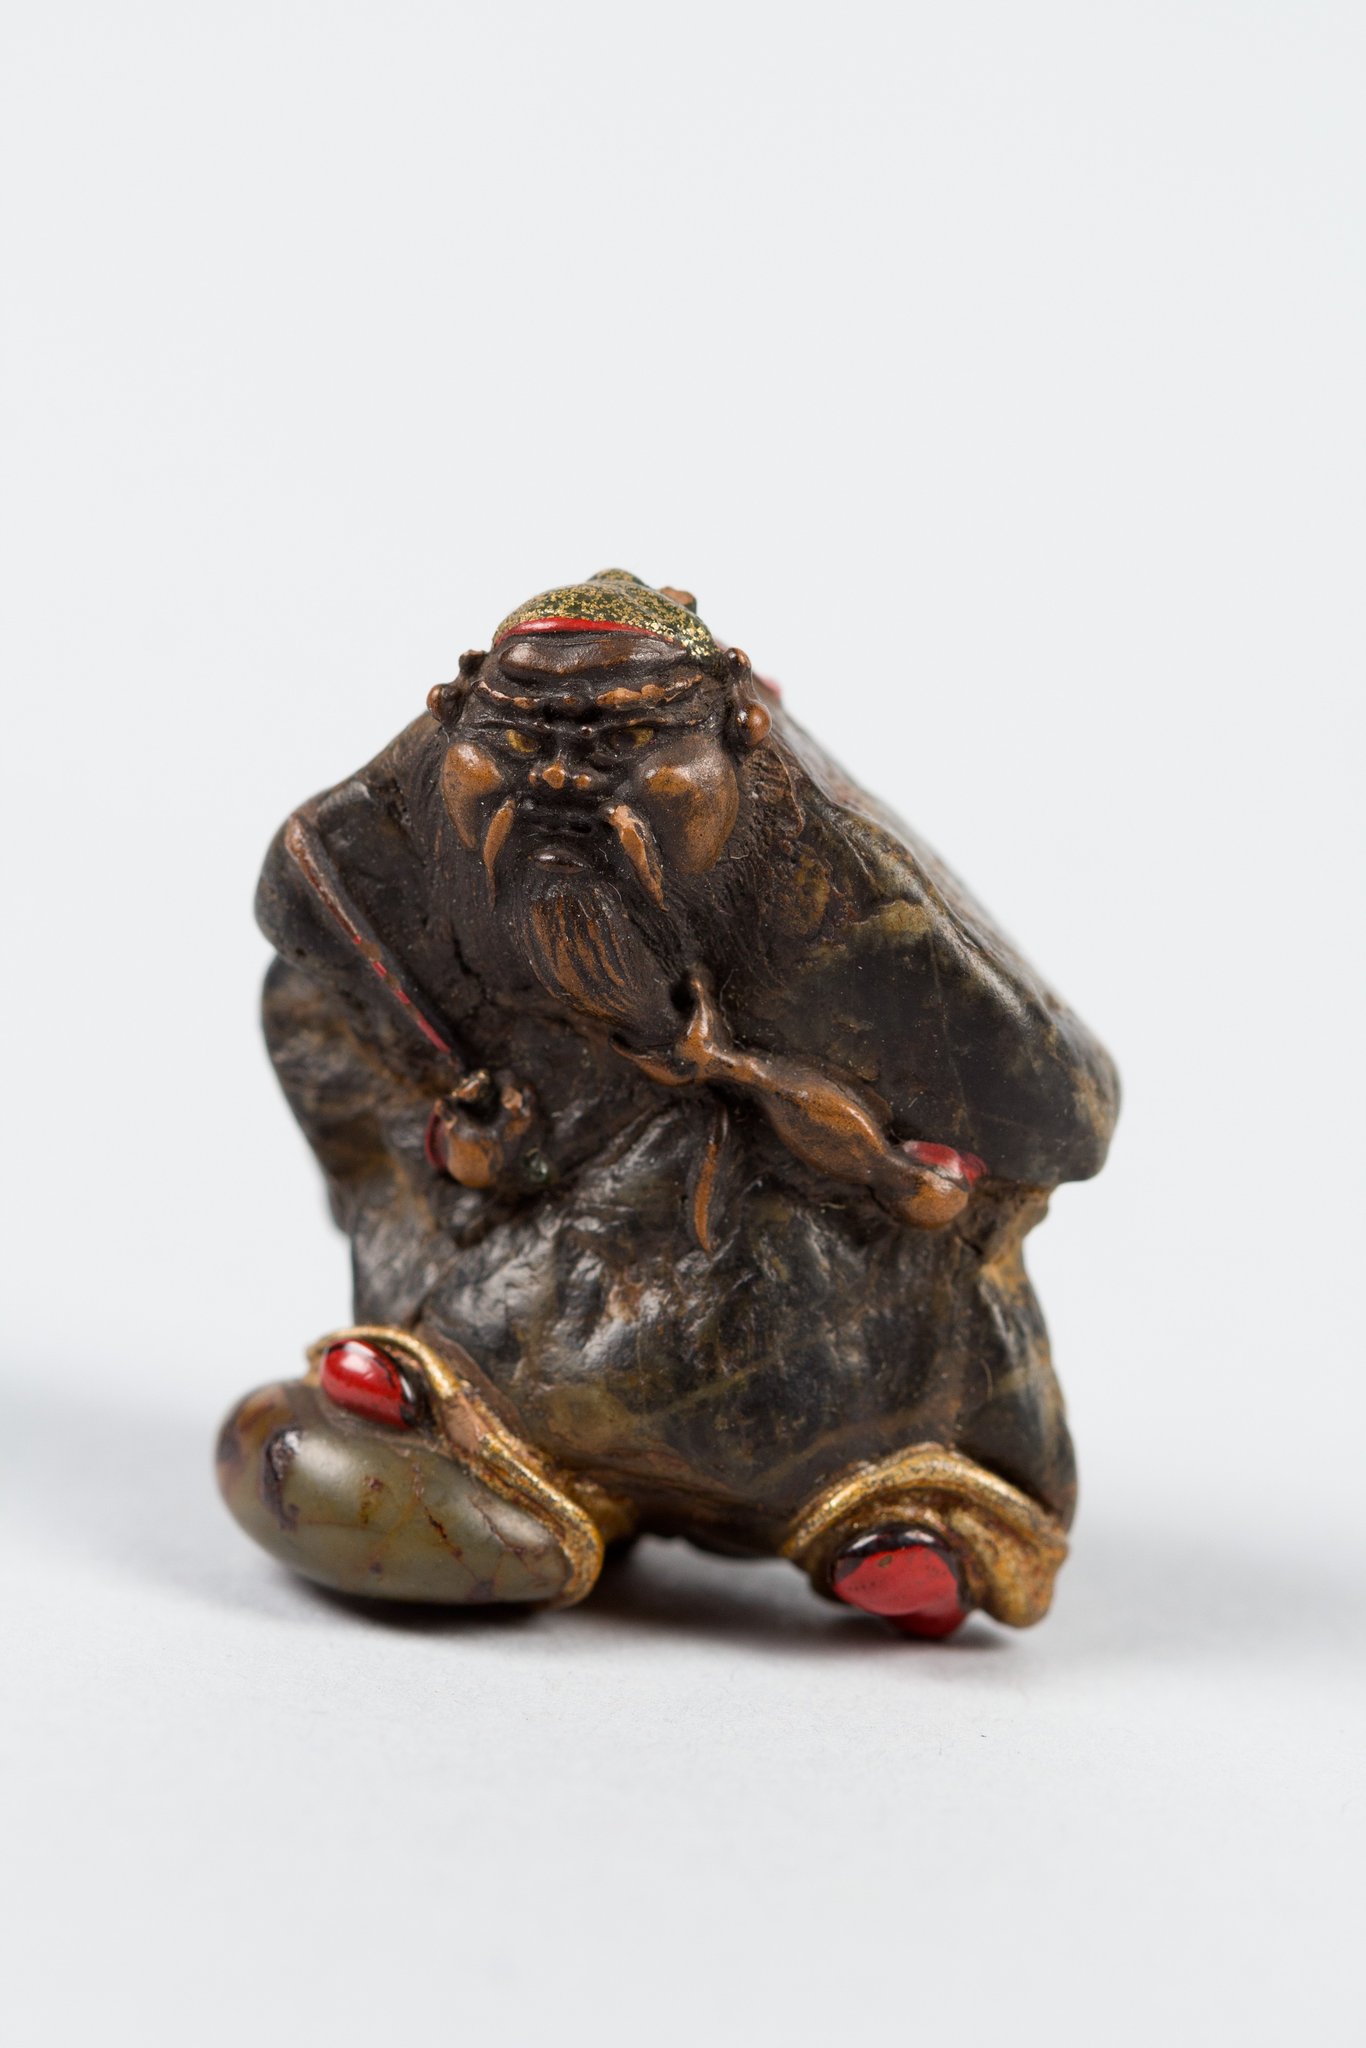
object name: netsuke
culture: japanese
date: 1801-1900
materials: enamel, gilt, metal, stone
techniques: inlay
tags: men